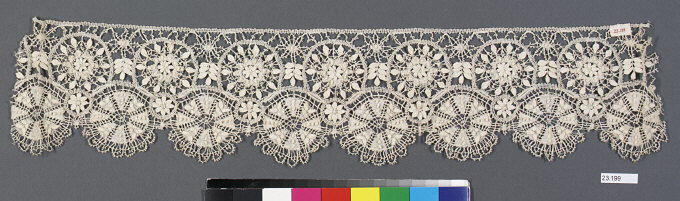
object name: edging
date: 1850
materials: linen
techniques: lace